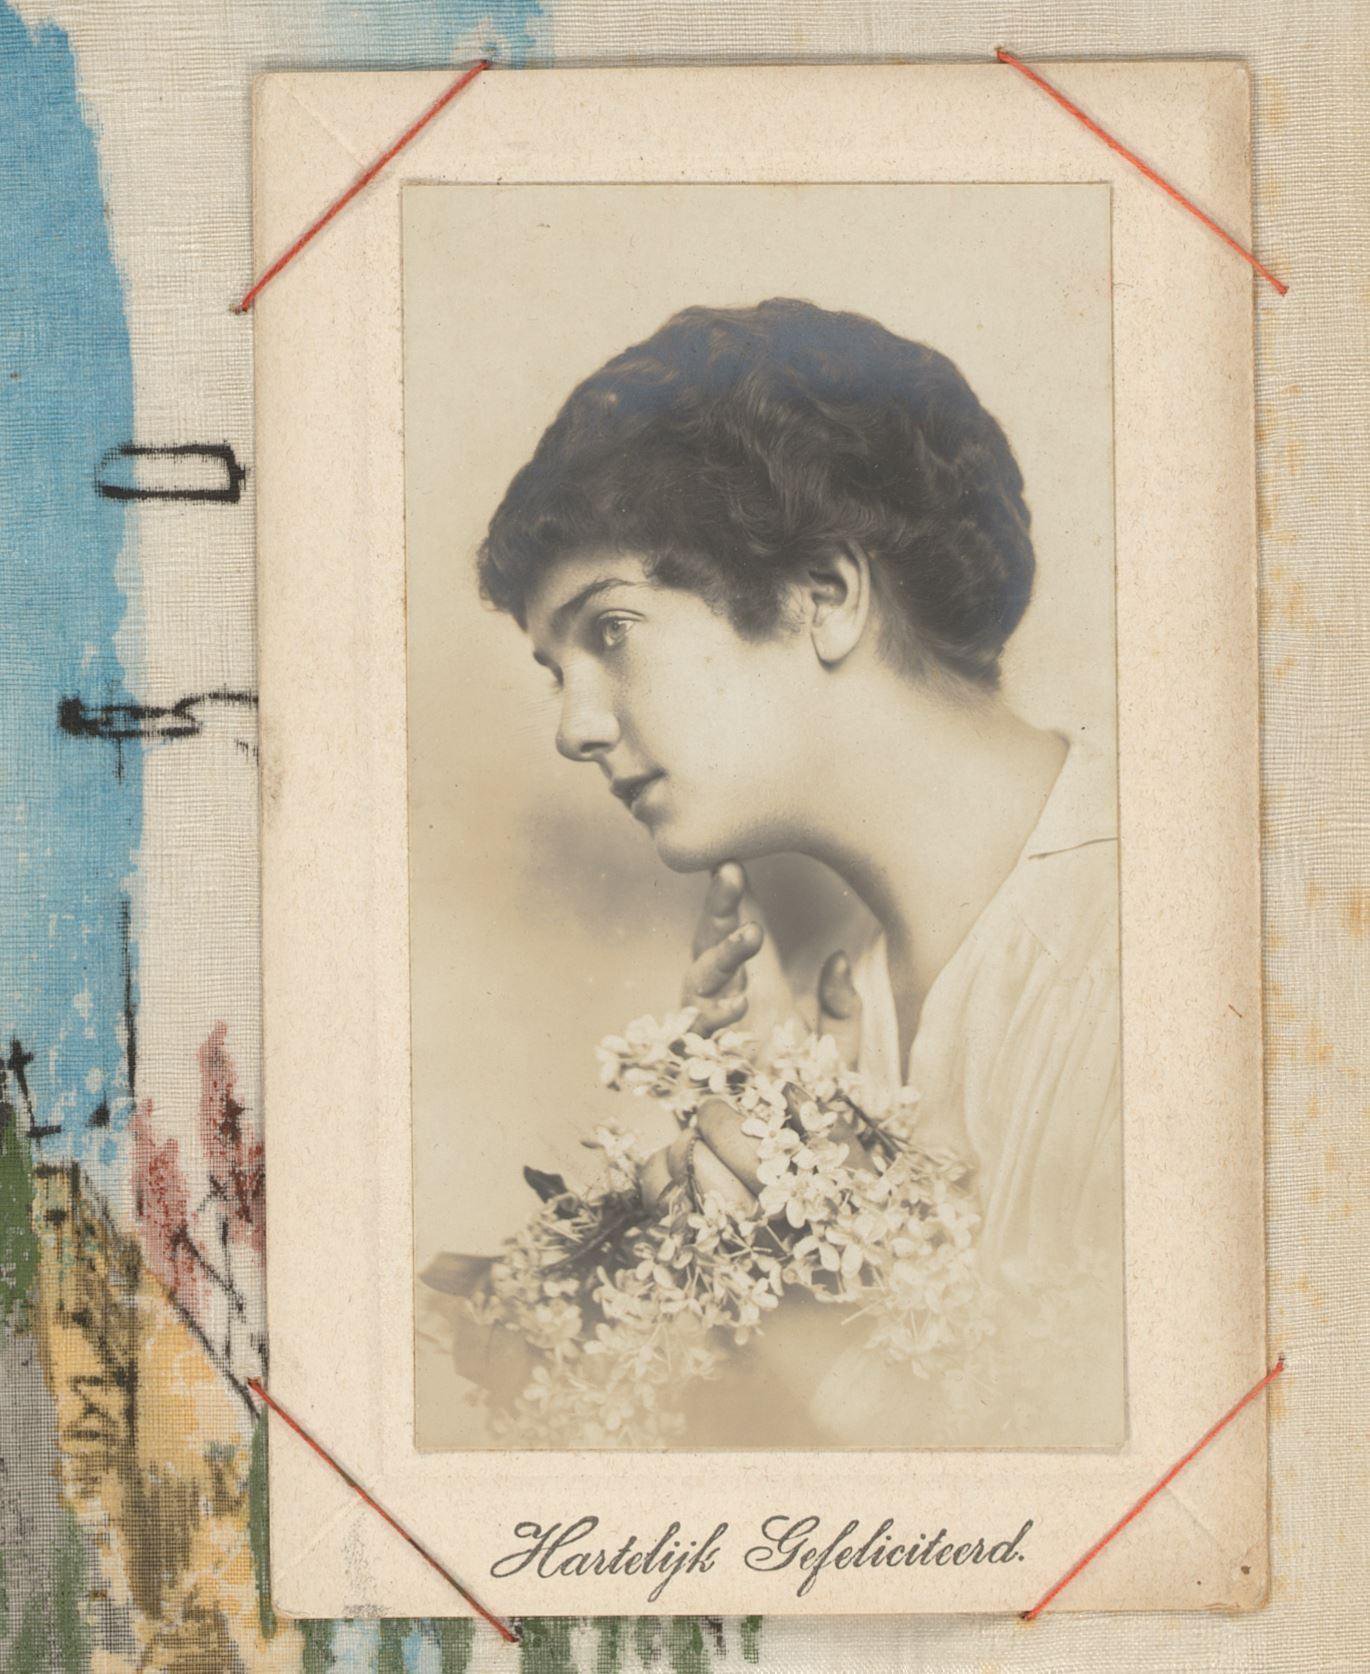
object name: album leaf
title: Hartelijk Gefeliciteerd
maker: Anonymous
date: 1880-1920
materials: paint, photographic support, silk, textile, watercolor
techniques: brush, gelatin silver print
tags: flowers, adult woman, historical persons